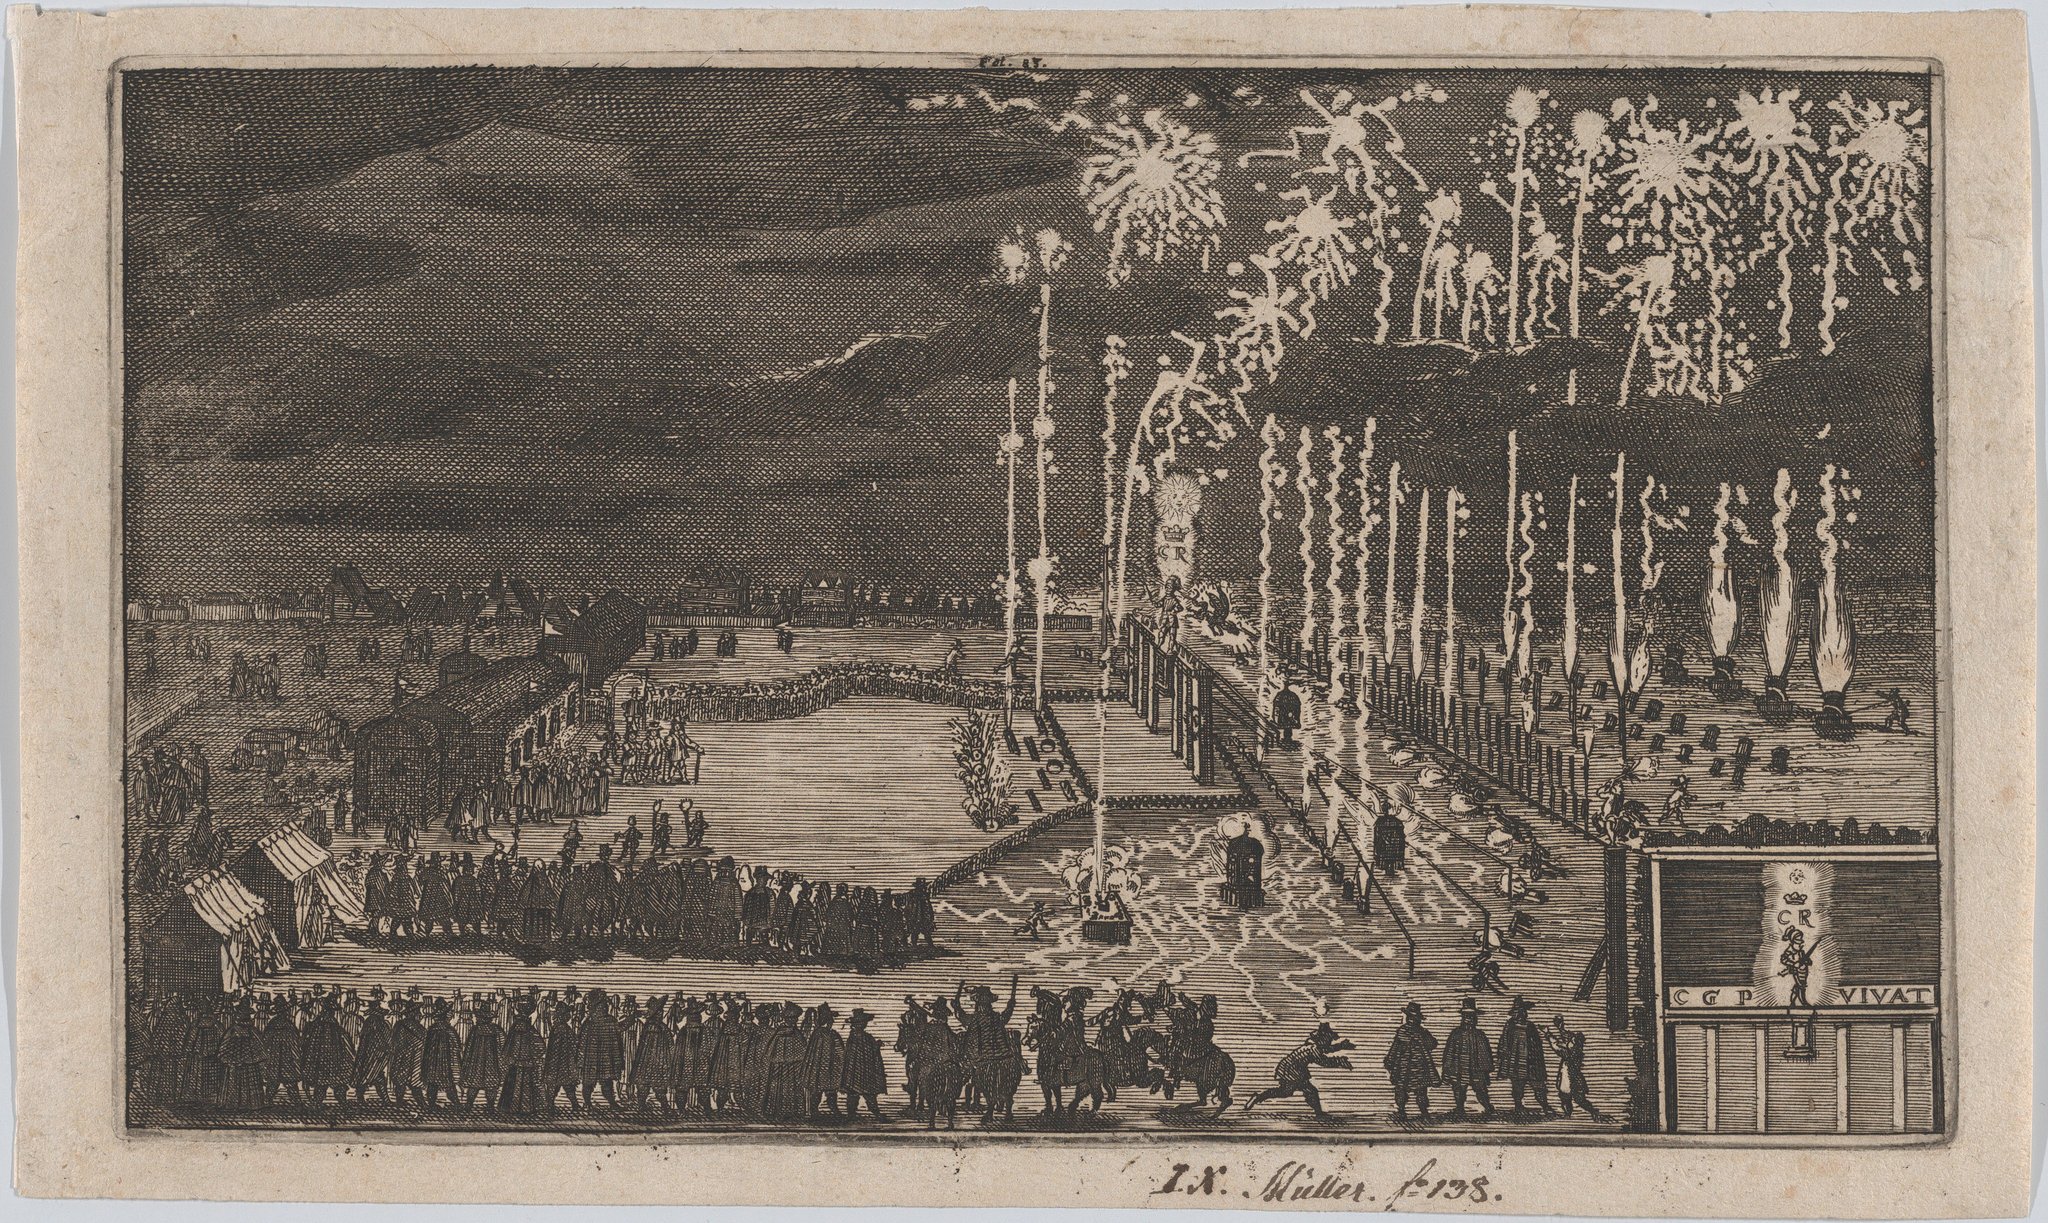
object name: print, fete, ornament architecture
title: Firework display, Nuremberg 1649, reduced copy of 'Kurze Beschreibung dess kunstlichen Feuerwerkes ...'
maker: anonymous, german, 17th century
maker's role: artist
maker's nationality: german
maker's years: 1600-1700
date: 1649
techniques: etching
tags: fireworks